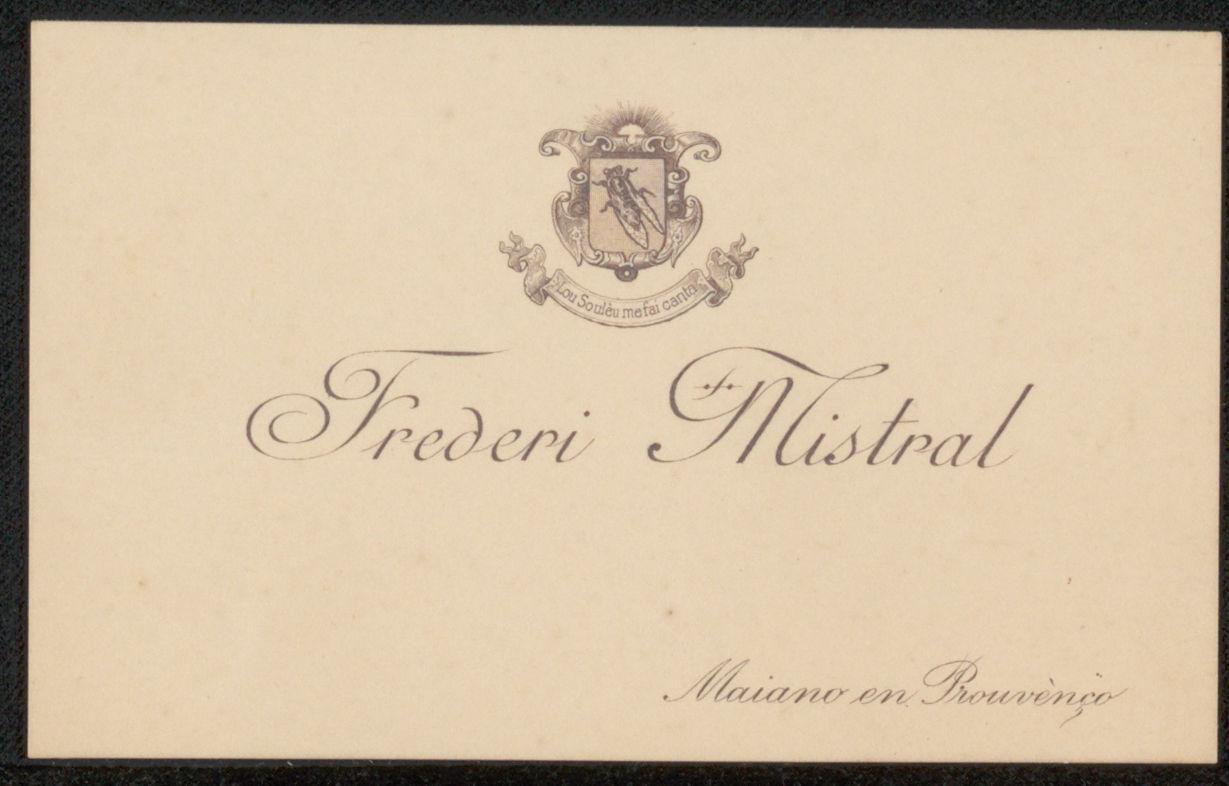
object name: visiting card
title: Visitekaartje aan Philip Zilcken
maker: frédéric mistral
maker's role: schrijver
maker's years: 1830-1914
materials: cardboard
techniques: printing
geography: maillane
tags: the hague, painter, draughtsman, philip zilcken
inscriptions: collector's mark: ‘RPK’